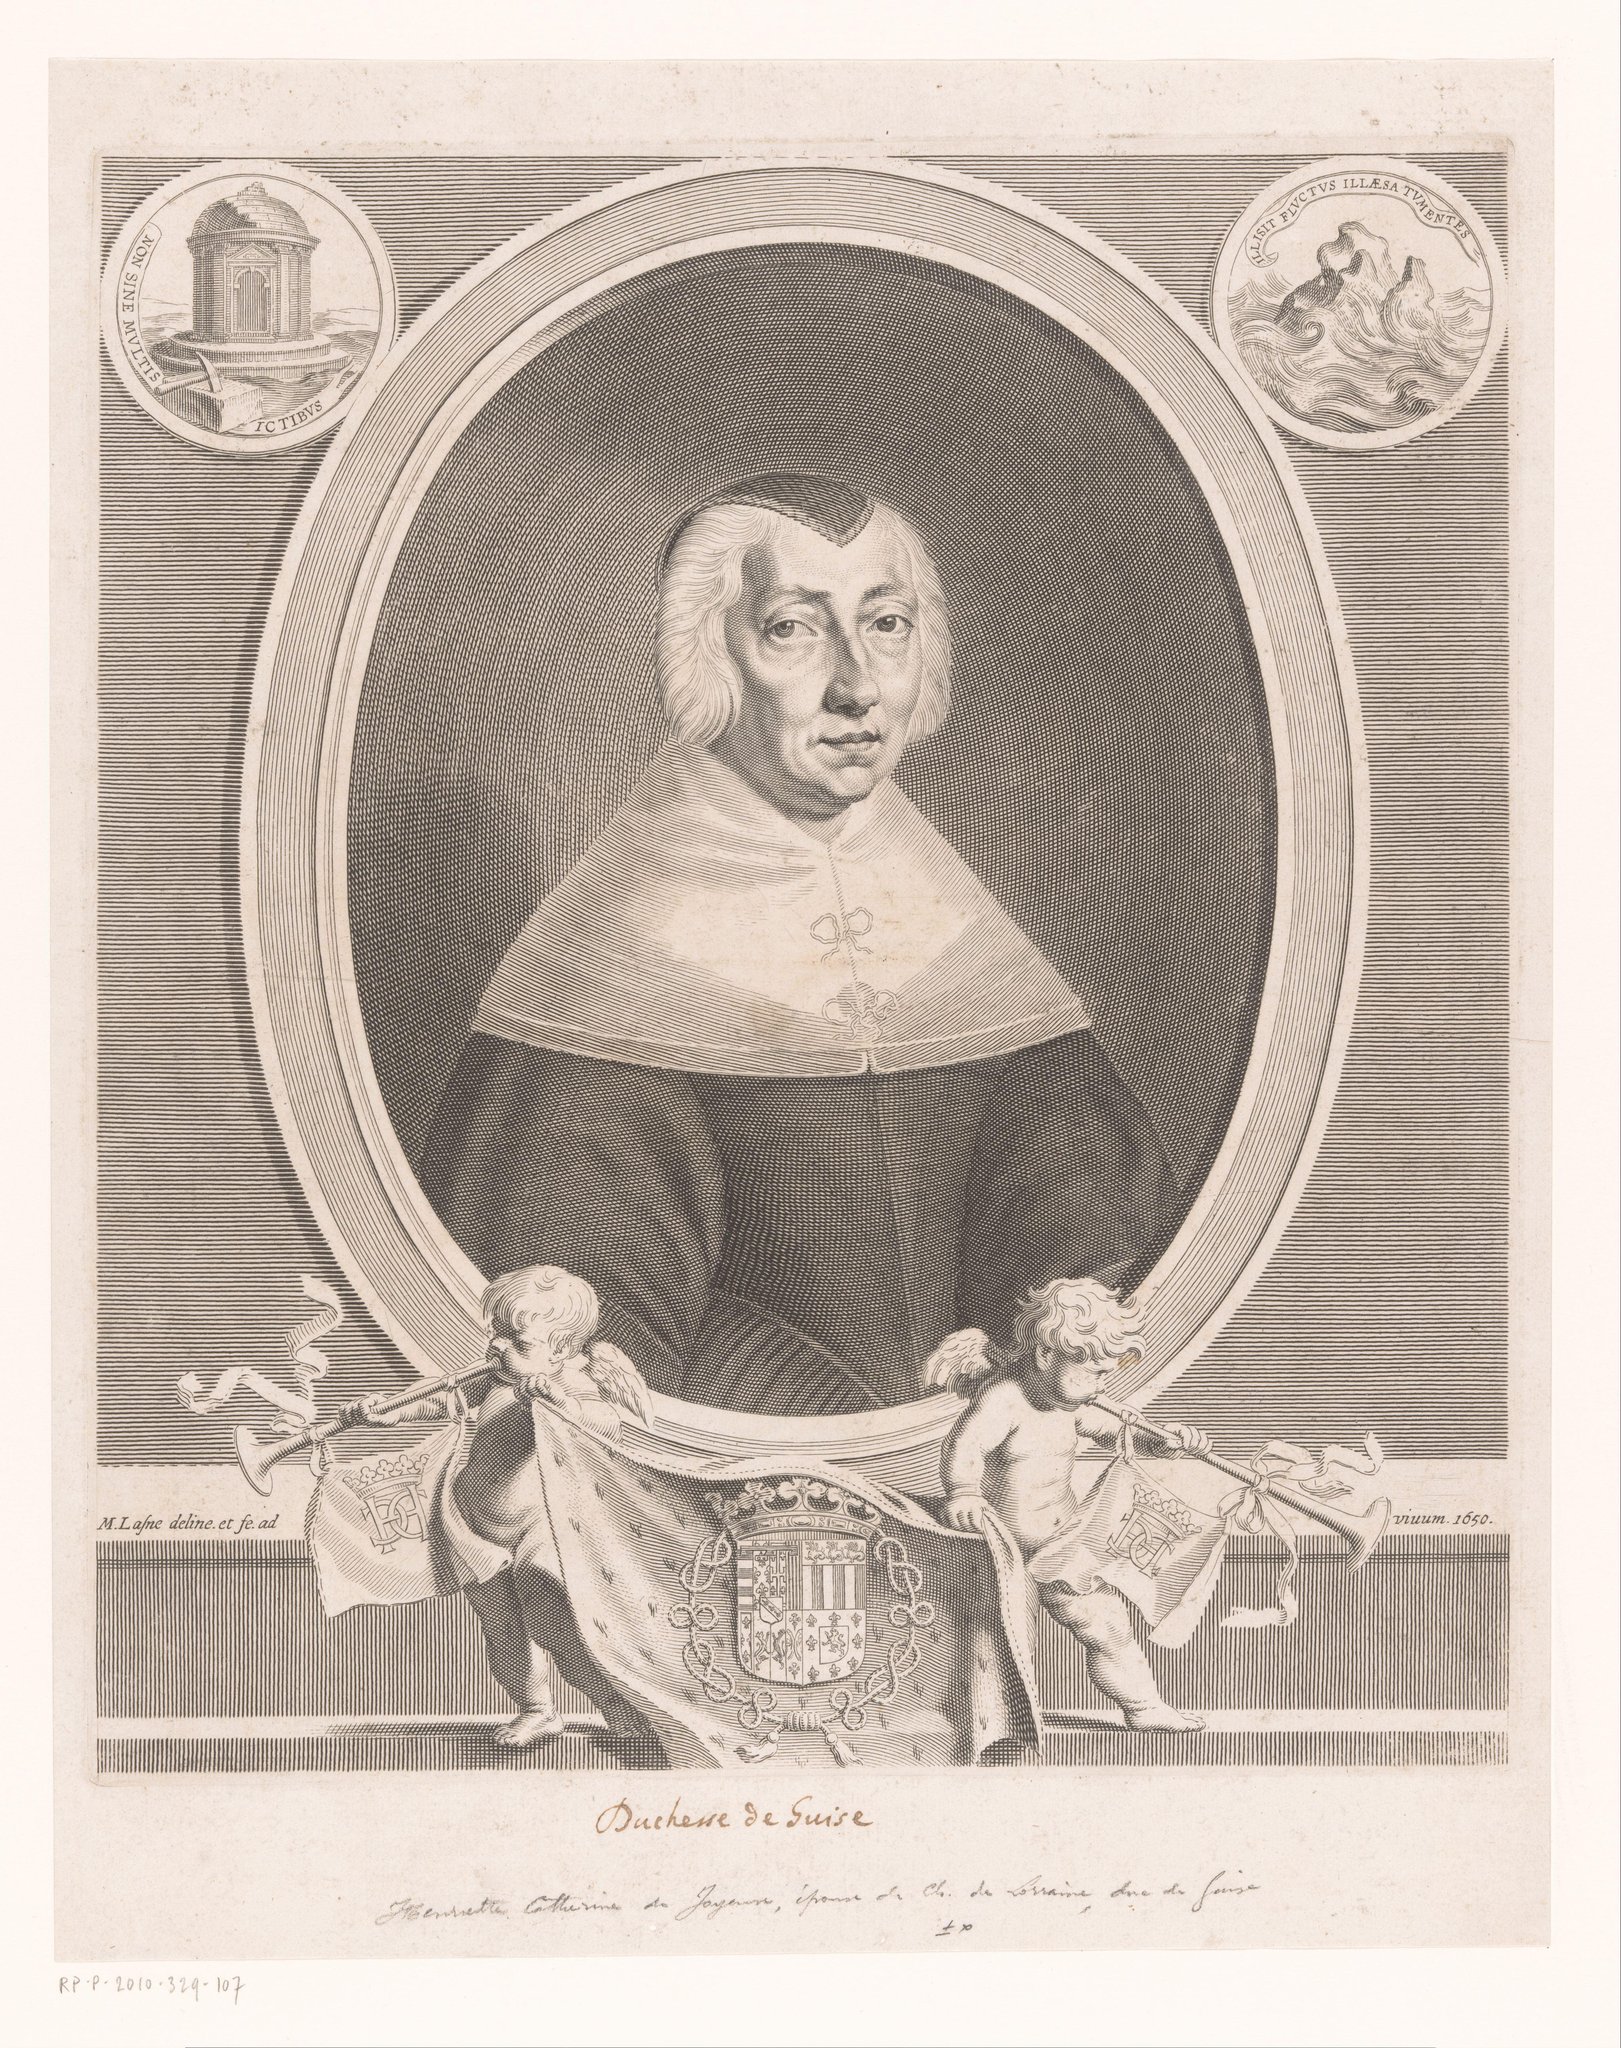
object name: print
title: Portret van mogelijk Henriette-Catherine de Joyeuse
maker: michel lasne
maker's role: print maker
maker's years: 1590-1667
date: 1650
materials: paper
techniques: engraving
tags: historical persons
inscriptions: collector's mark: Lugt 2228, inscription: ‘Duchesse de Suisse’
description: Portret ten halven lijve, met brede over de schouders liggende kraag. In ovale lijst met onderaan twee bazuin blazende putti.